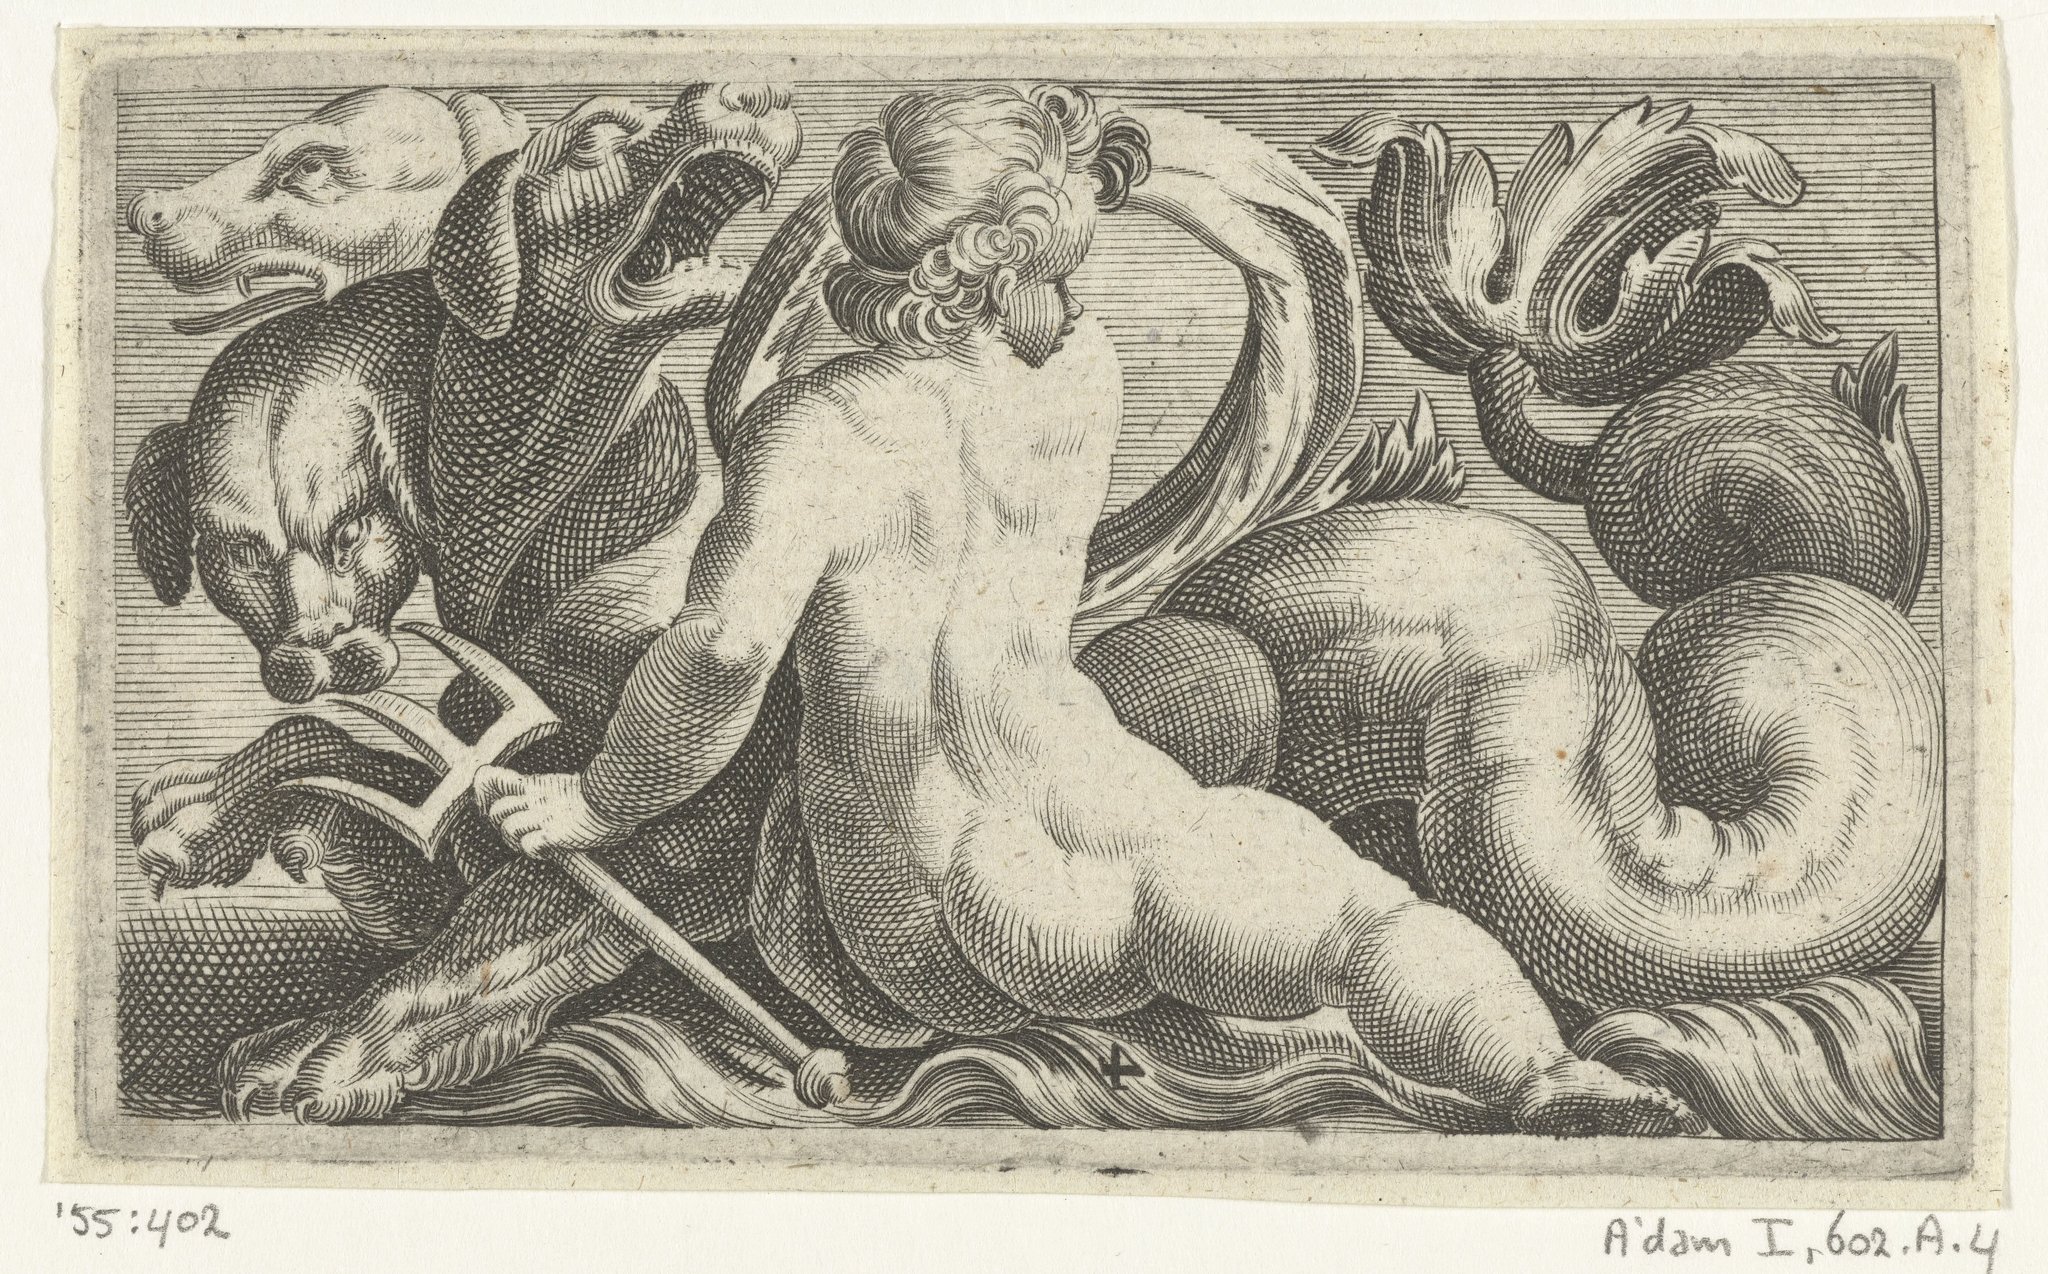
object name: print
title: Putti op zeewezens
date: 1605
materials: paper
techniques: engraving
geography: germany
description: Tegenzijdige kopie naar een prent van Giovanni Andrea Maglioli.